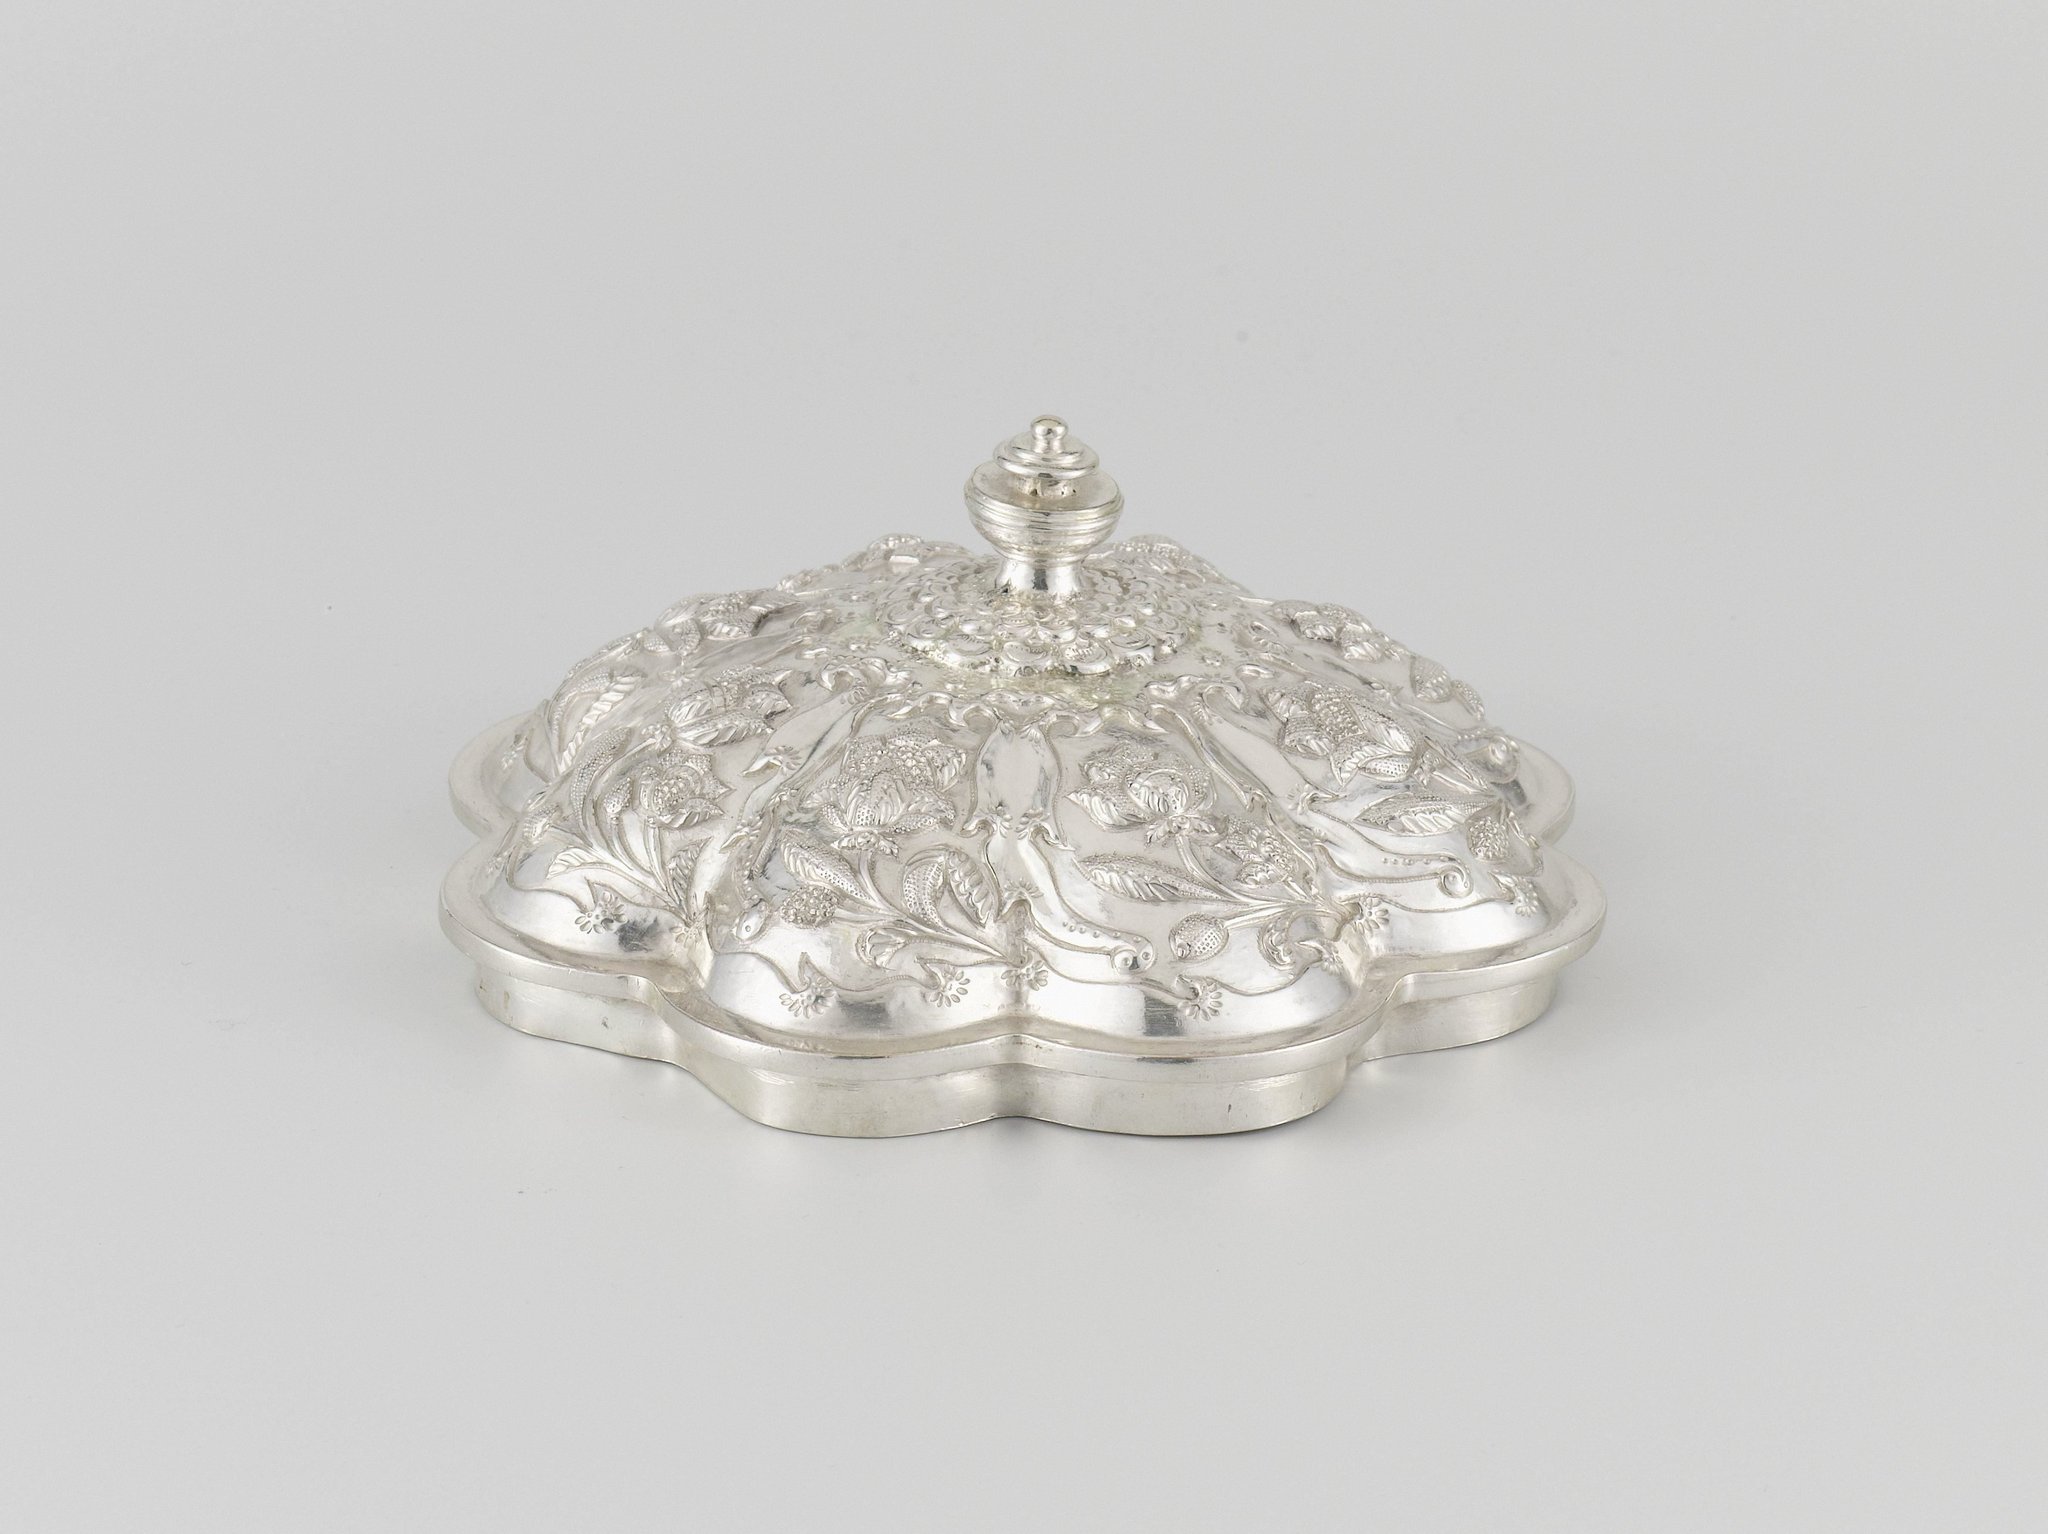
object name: lid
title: Water Bowl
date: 1679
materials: silver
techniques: metalworking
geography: batavia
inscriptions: town mark, mark: ‘M’, mark: ‘G’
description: This bowl was used for serving chilled water. It bears the silver hallmark of the Amsterdam silversmith Jacob de Grebber. In the 1670s, he travelled to Batavia (Jakarta), the centre of Dutch trade in Asia, where this bowl and dish were made. They were undoubtedly intended for Western customers; featuring large, sculptural flowers, the decoration adheres to the Dutch fashion of the time.